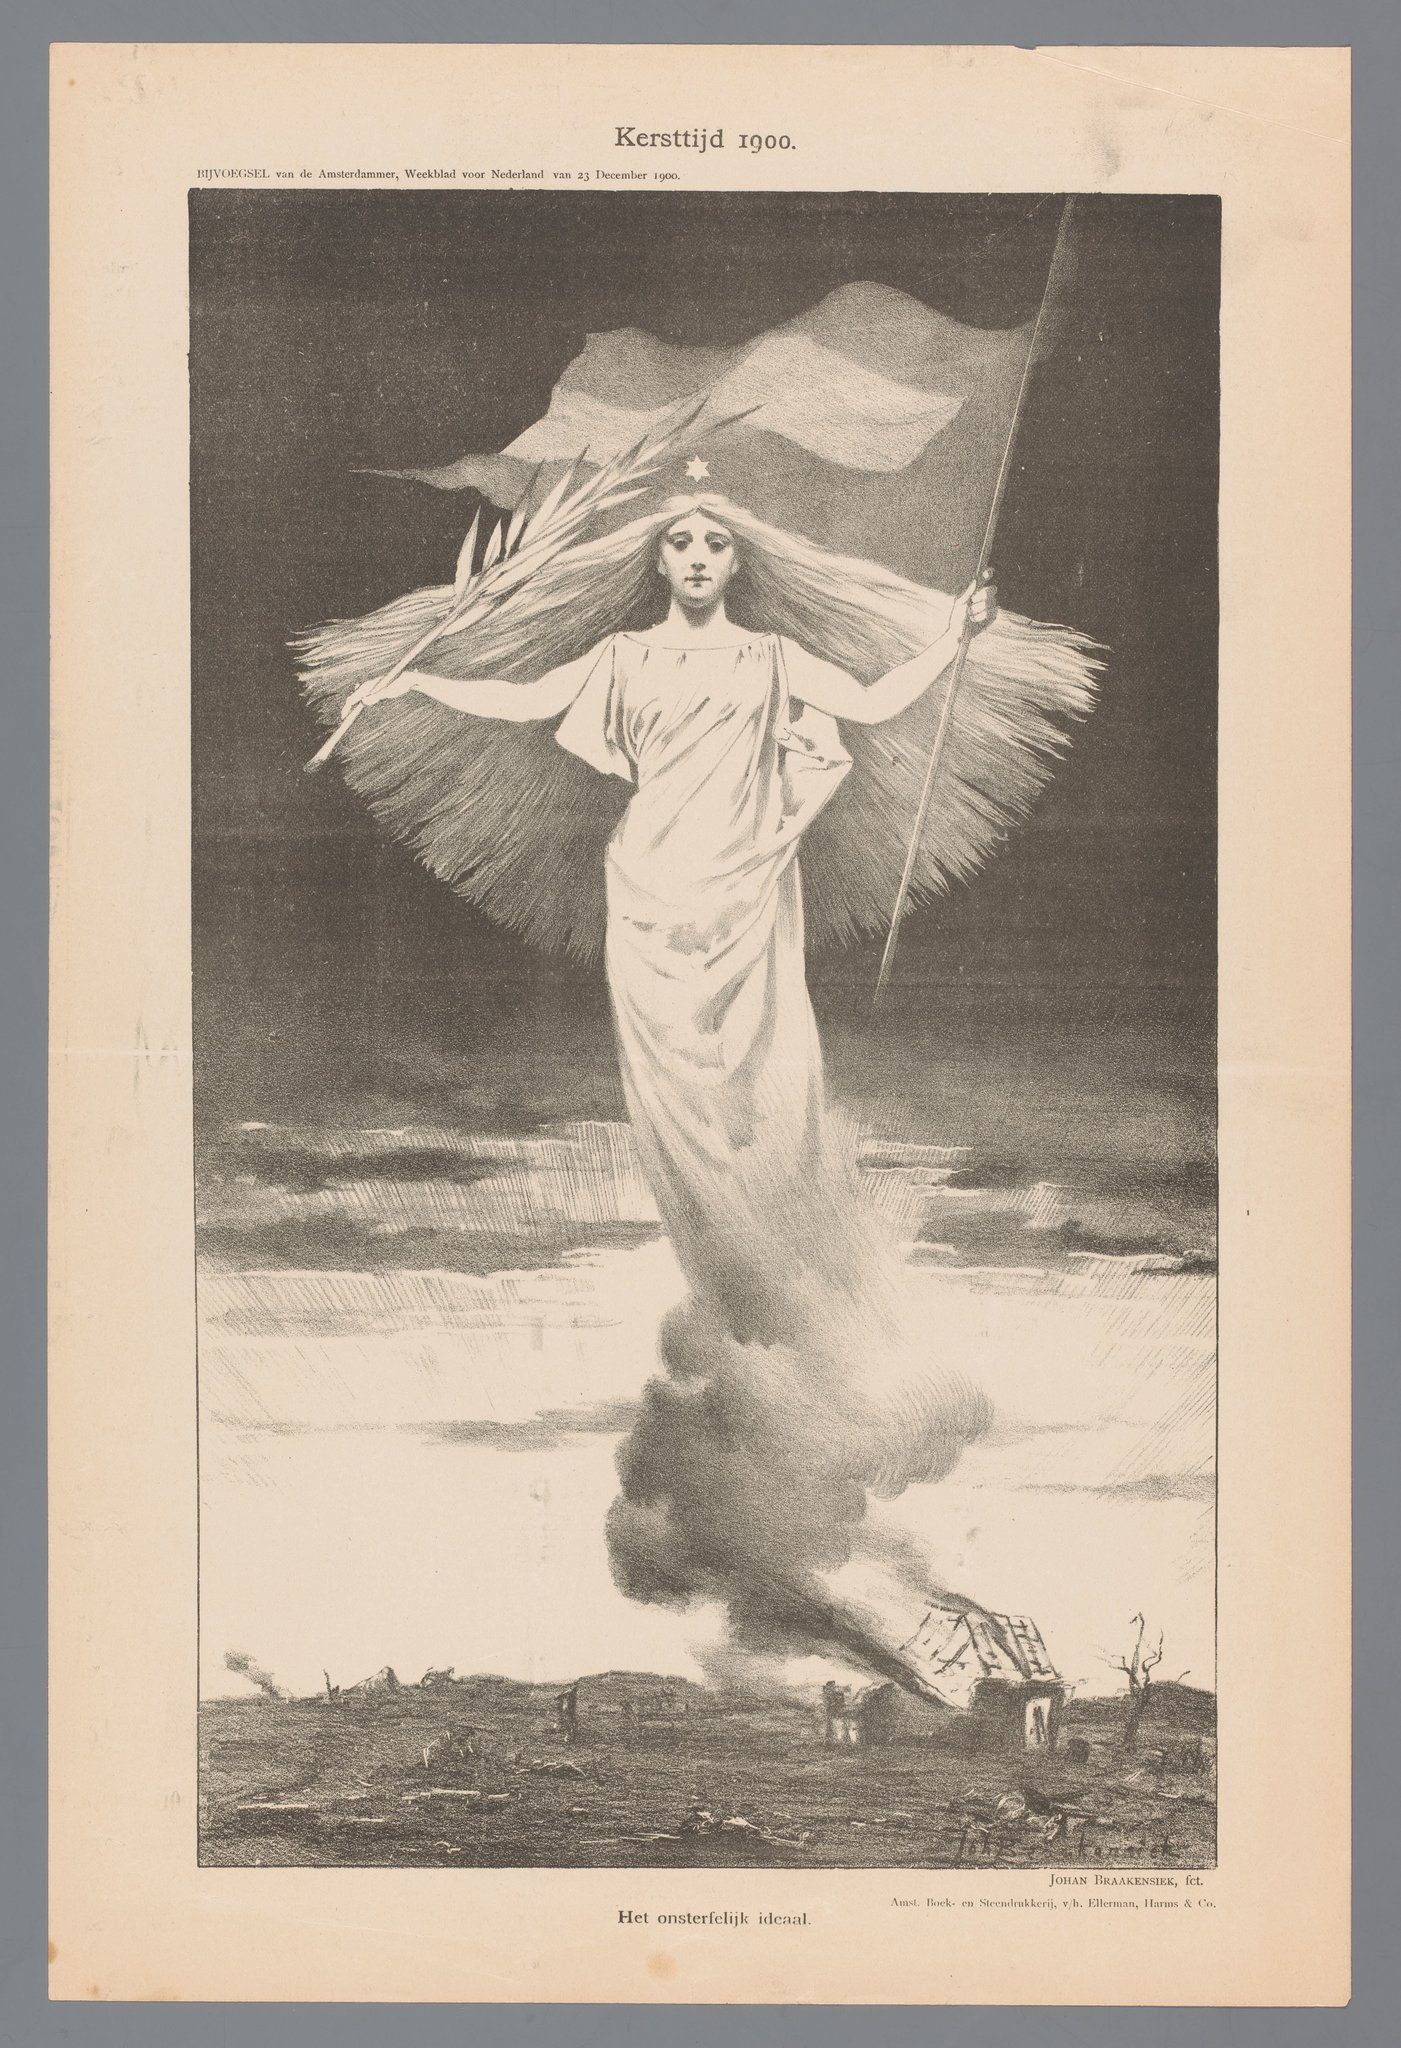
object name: cartoon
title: Kersttijd 1900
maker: johan braakensiek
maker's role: draughtsman, print maker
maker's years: 1858-1940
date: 1900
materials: paper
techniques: lithograph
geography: amsterdam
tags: symbols, allegories of peace, 'pax'; 'pace' (ripa), political caricatures and satires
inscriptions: date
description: Prent uit het bijvoegsel van: De Amsterdammer. Weekblad voor Nederland, 23 december 1900.